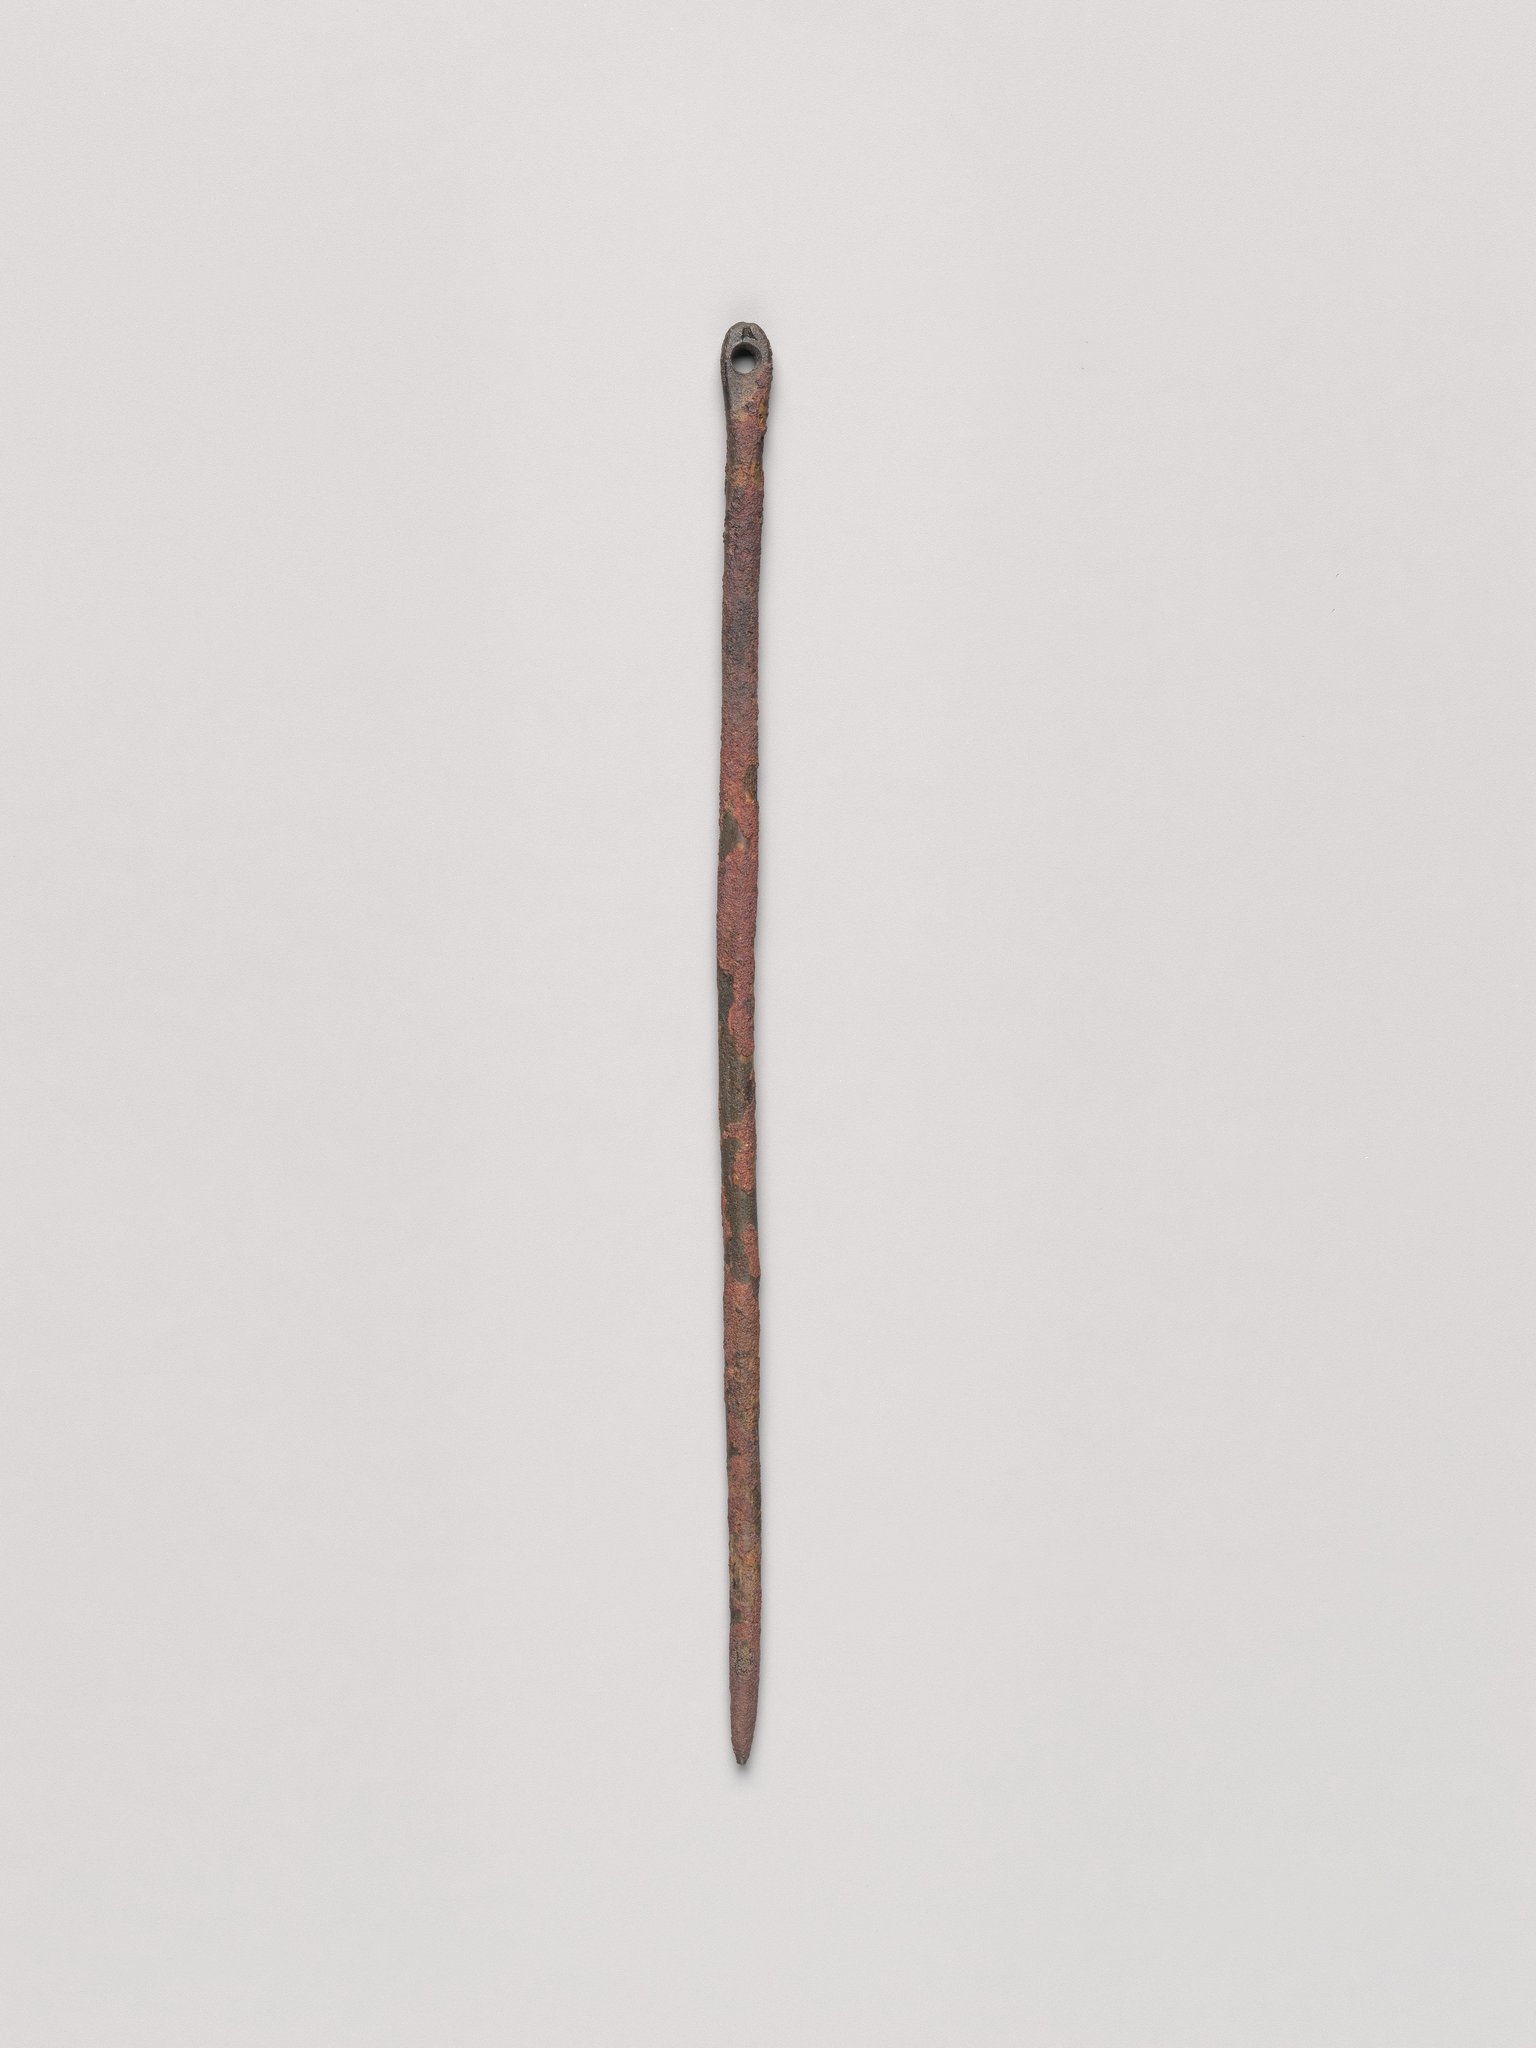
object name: needle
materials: bronze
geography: mesopotamia